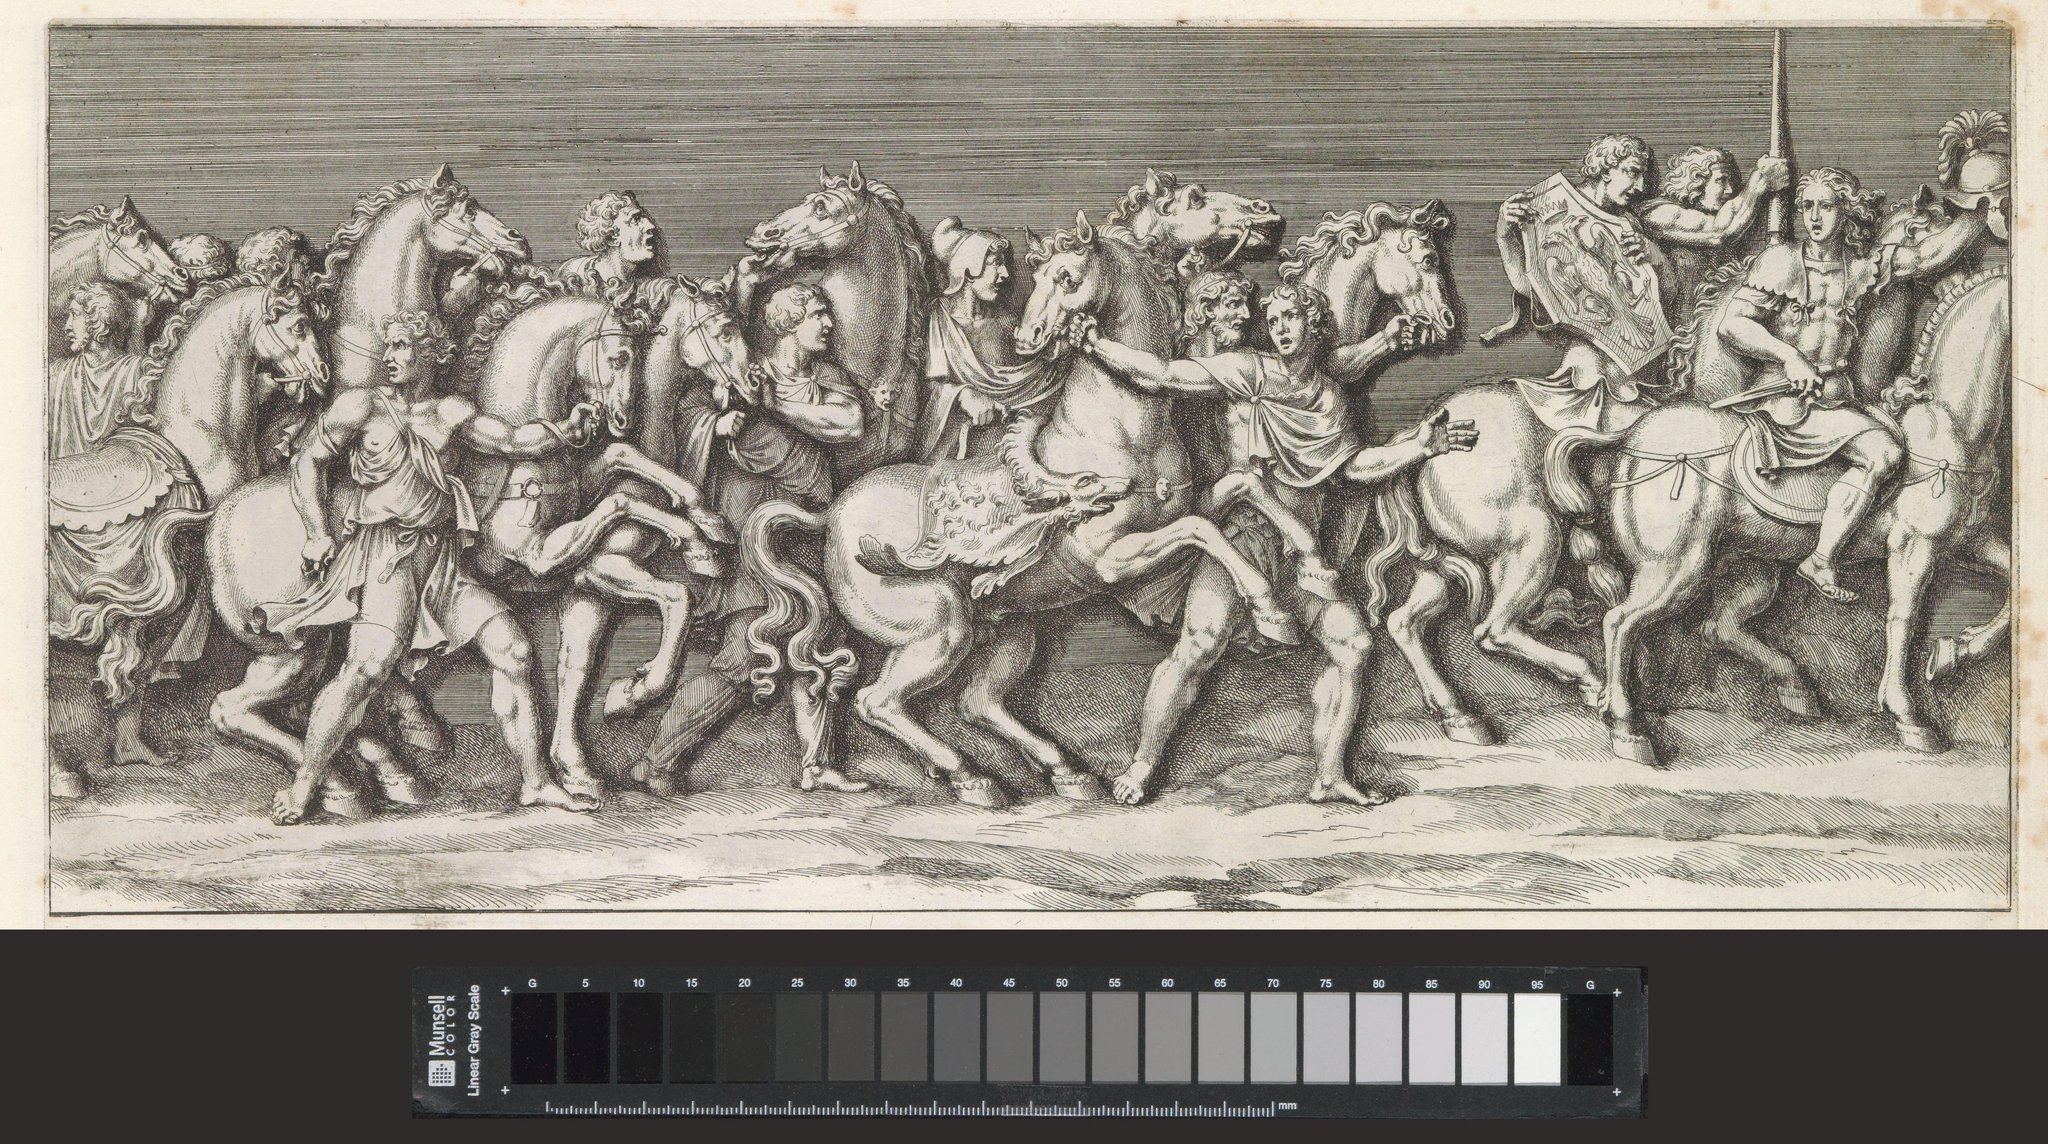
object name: print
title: Sigismundi Augusti Mantuam adeuntis profectio ac triumphus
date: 1680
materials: paper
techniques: etching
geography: italy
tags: triumphal entry and public reception, pageant, 'entrée solennelle', 'joyeuse entrée', military parade, pageant, the soldier; the soldier's life, the soldier; the soldier's life (+ cavalry, horsemen)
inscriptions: number: ‘15’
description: Prent maakt deel uit van een reeks van 25 prenten (+ titelprent) naar het stucwerk door Giulio Romano en Francesco Primaticcio in de Sala degli Stucchi in Palazzo del Te te Mantua.